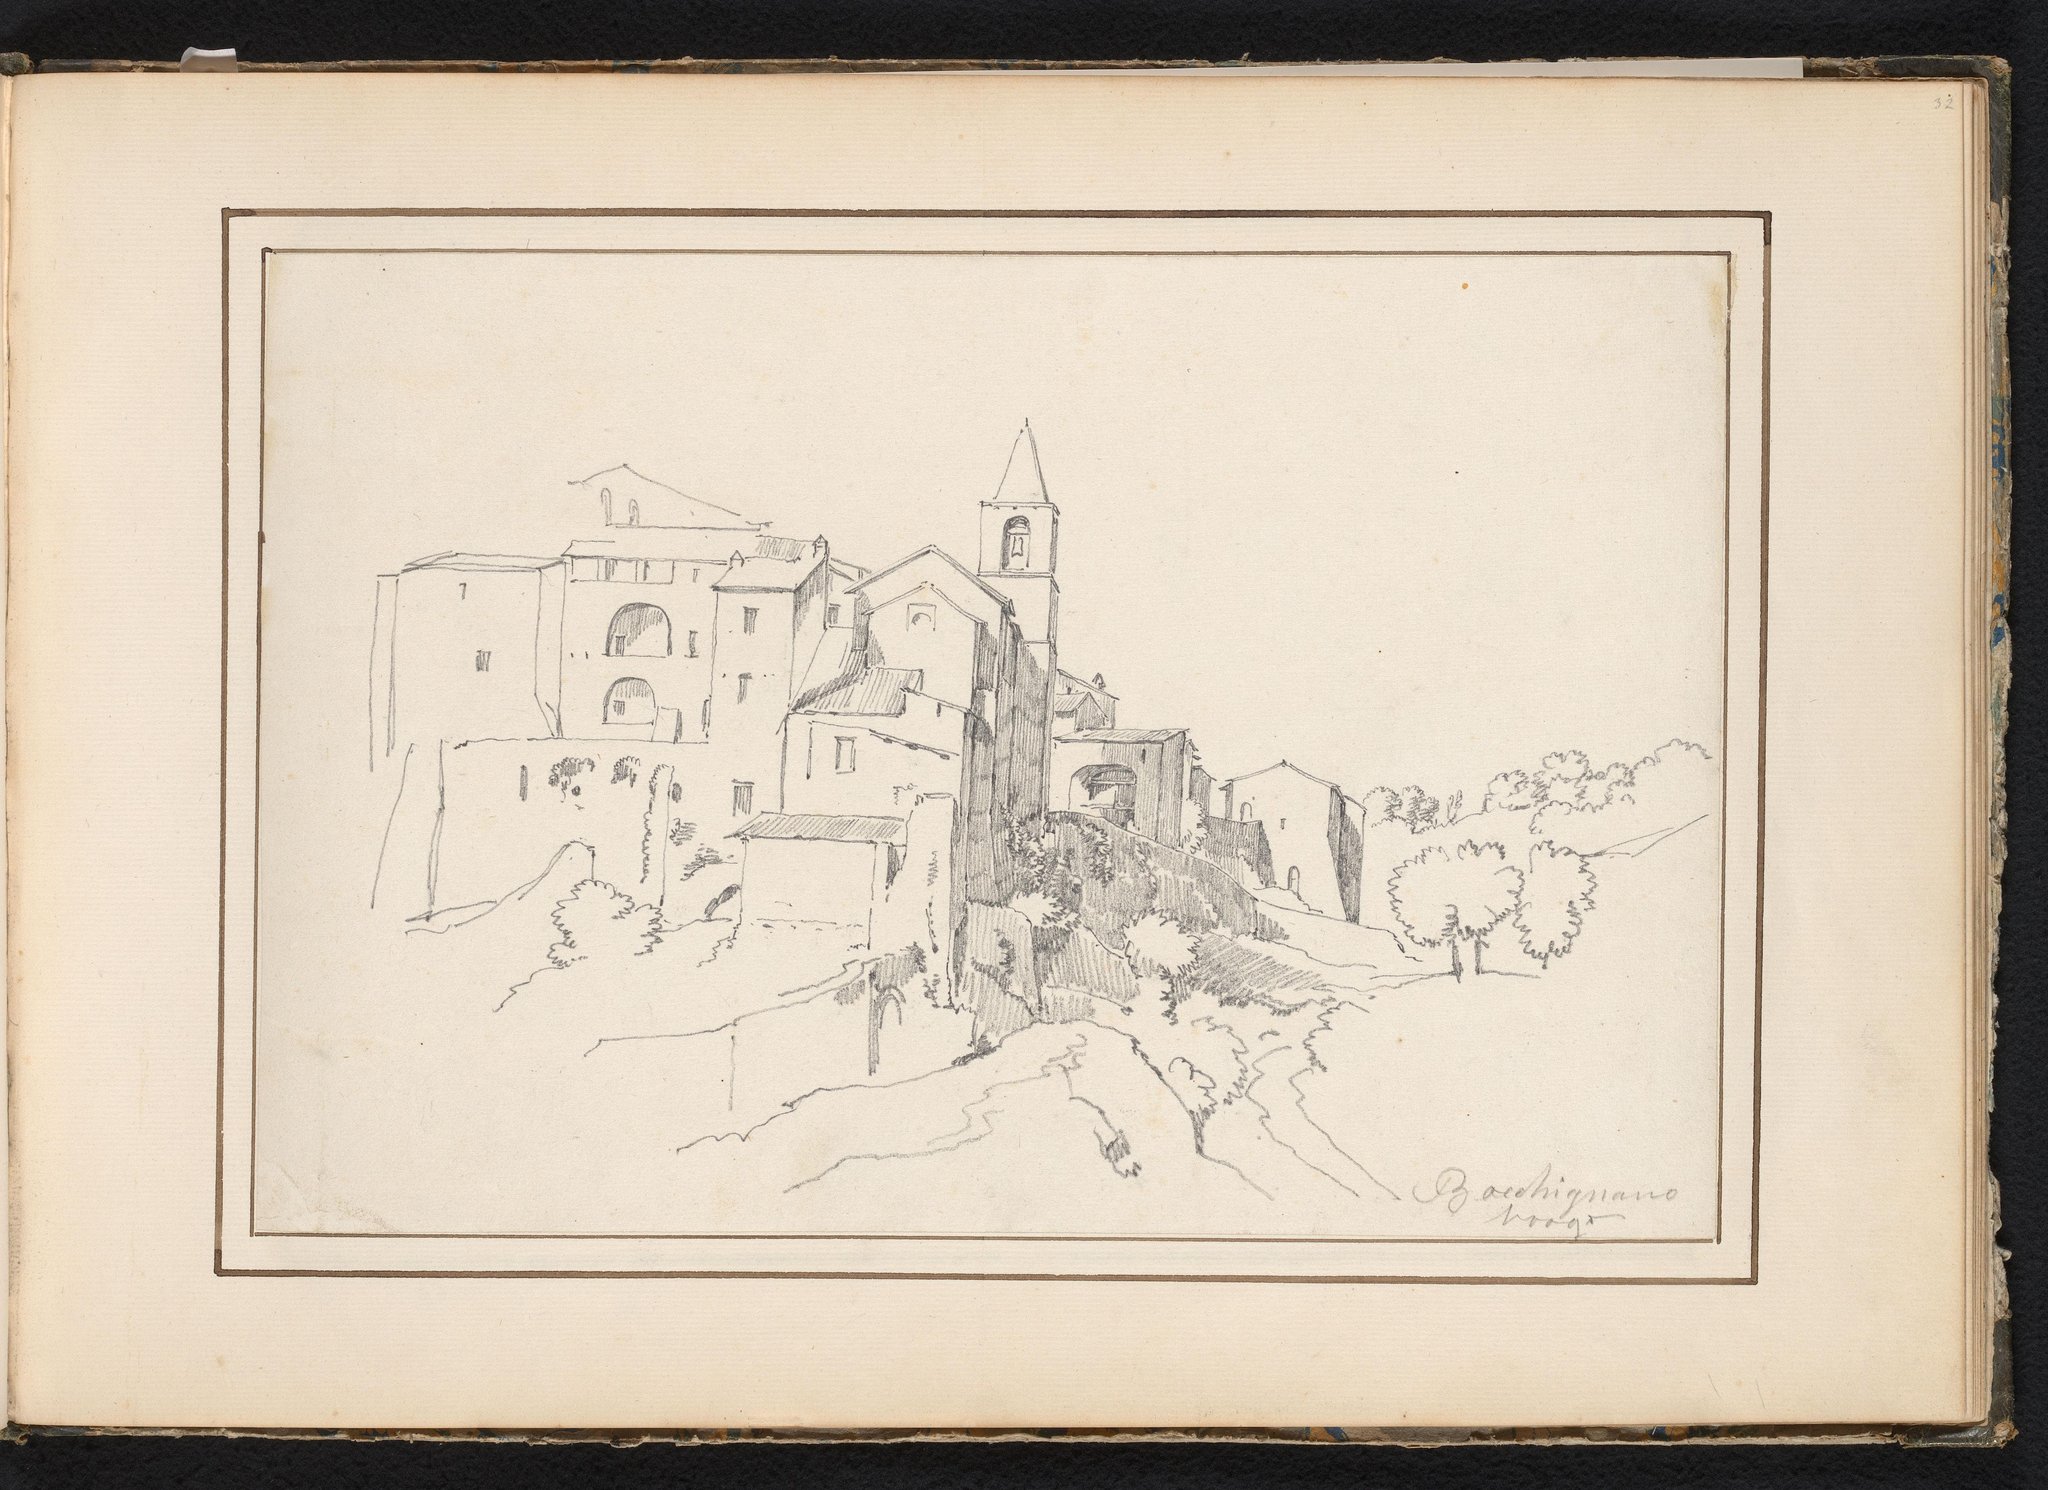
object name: album leaf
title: Gezicht op Bocchignano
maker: hendrik voogd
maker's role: draughtsman, painter, print maker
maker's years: 1768-1839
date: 1788-1839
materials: paper, pencil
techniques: pasting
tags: city-view in general; 'veduta', castle, bocchignano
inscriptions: inscription: ‘Bocchignano’